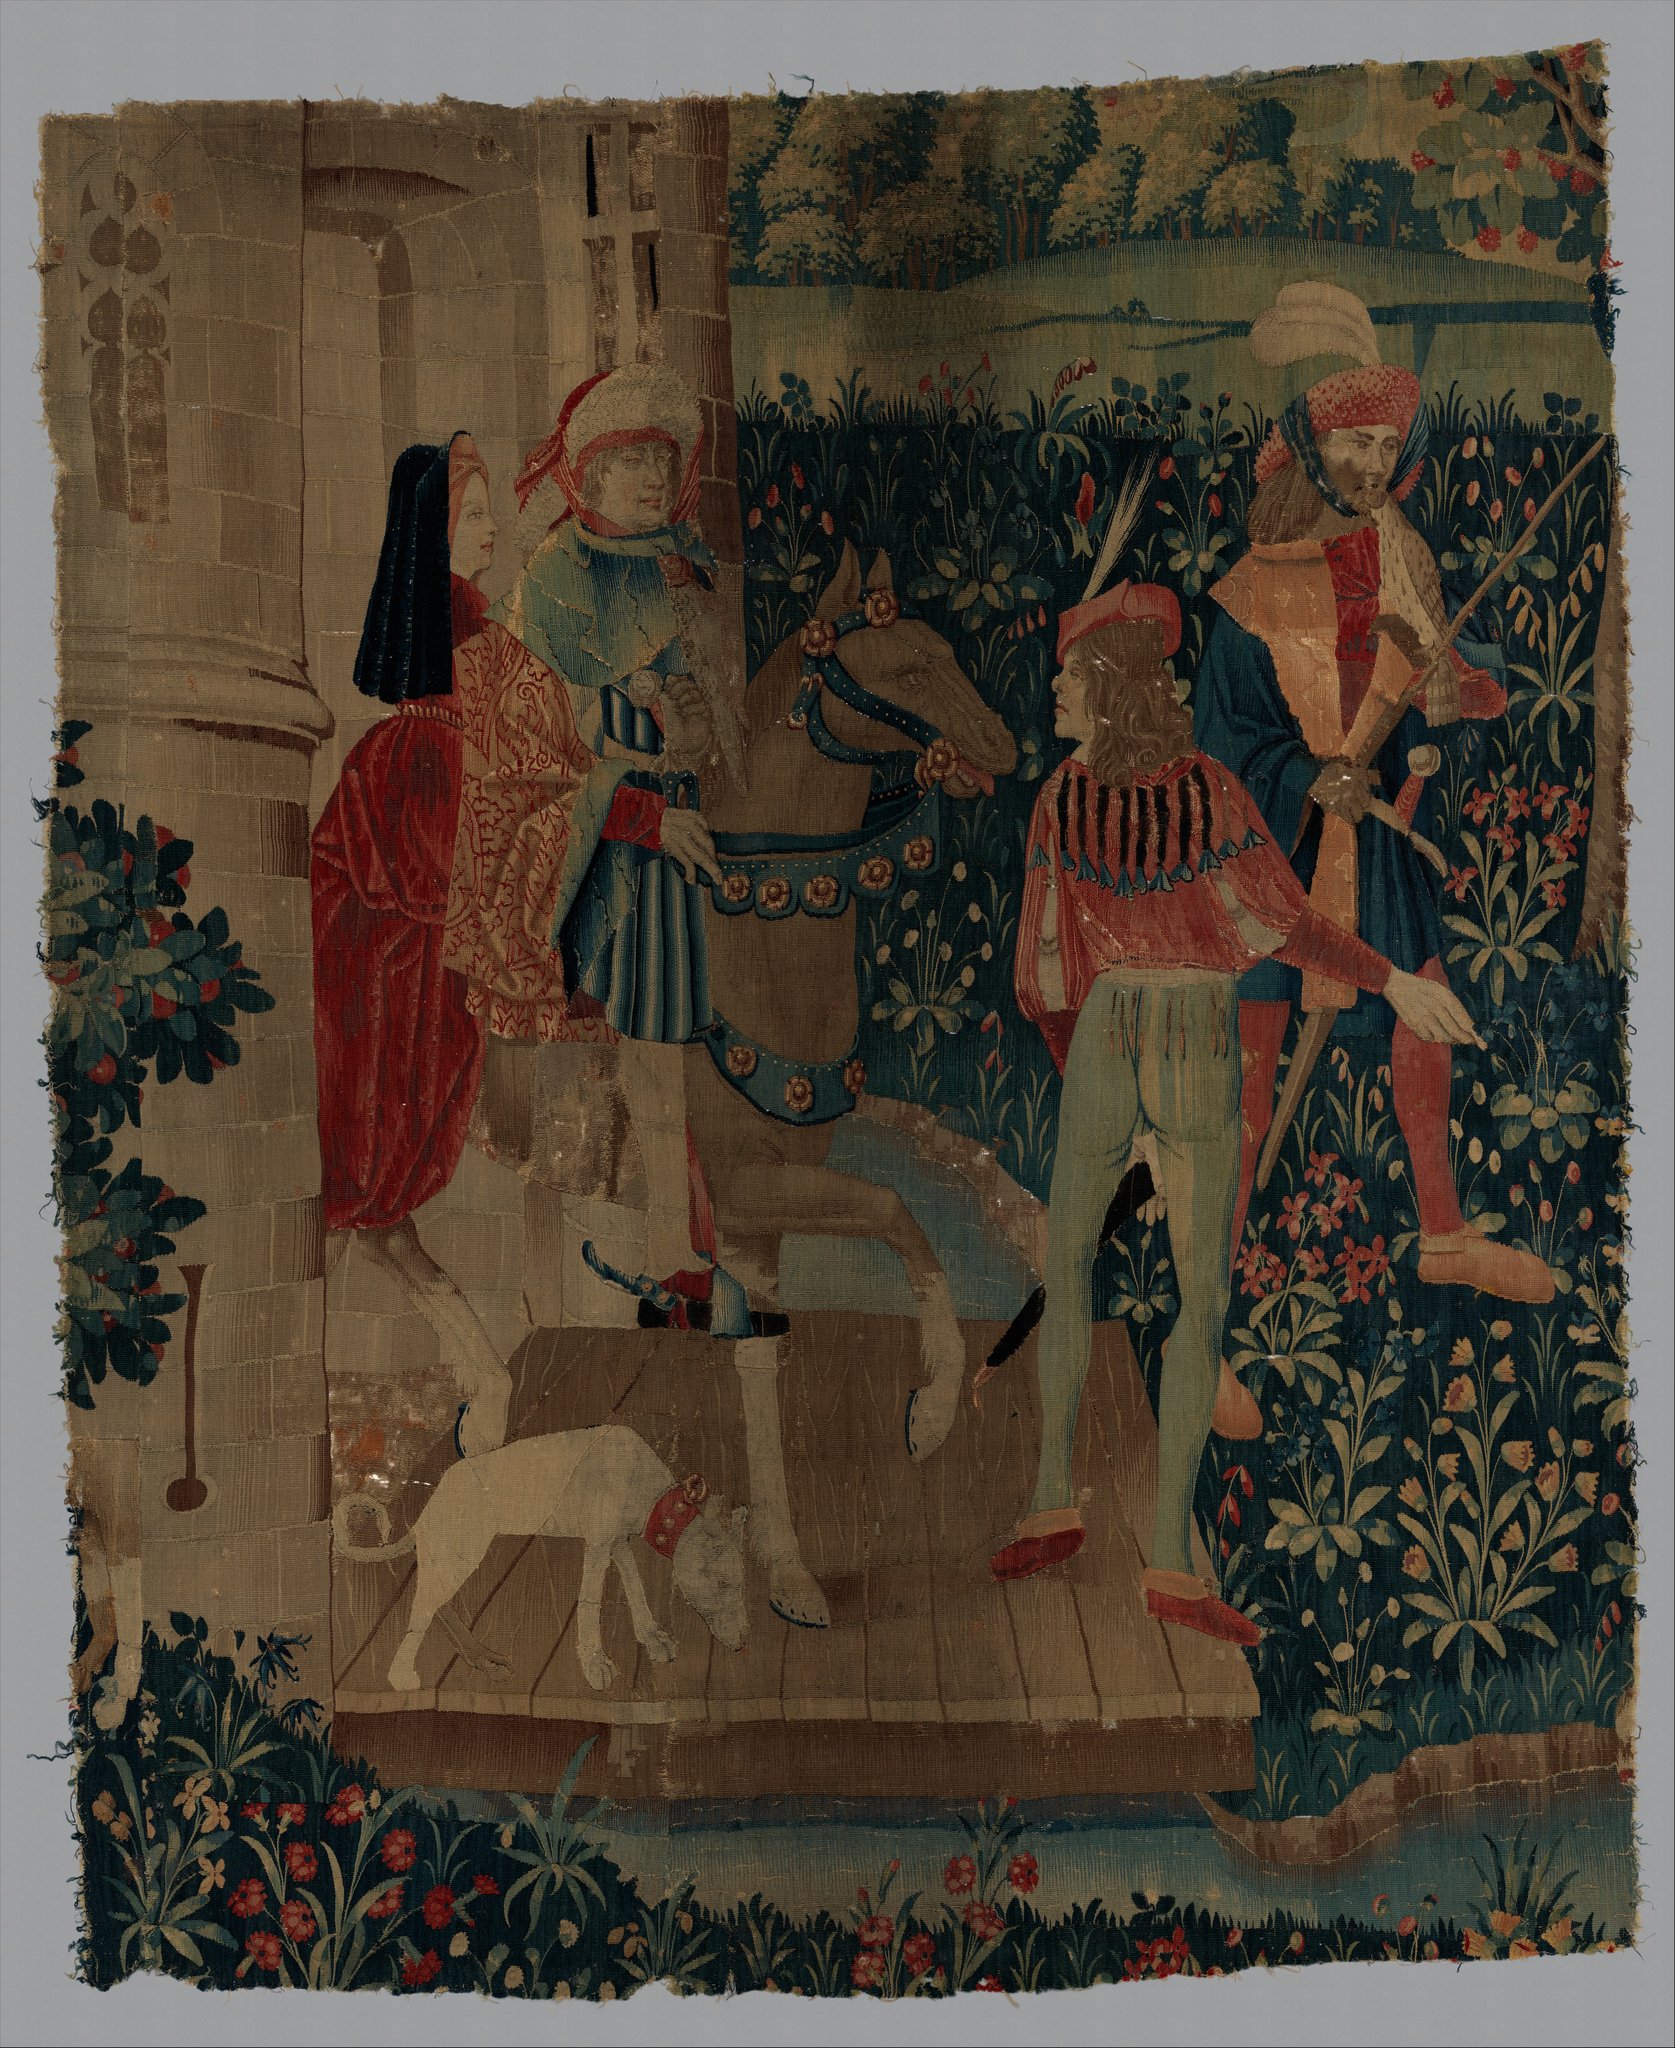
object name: tapestry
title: A Hunting Party Leaving a Castle (From Incidents in a Stag Hunt)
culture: south netherlandish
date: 1495-1515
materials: wool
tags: men,women,hunting,horses